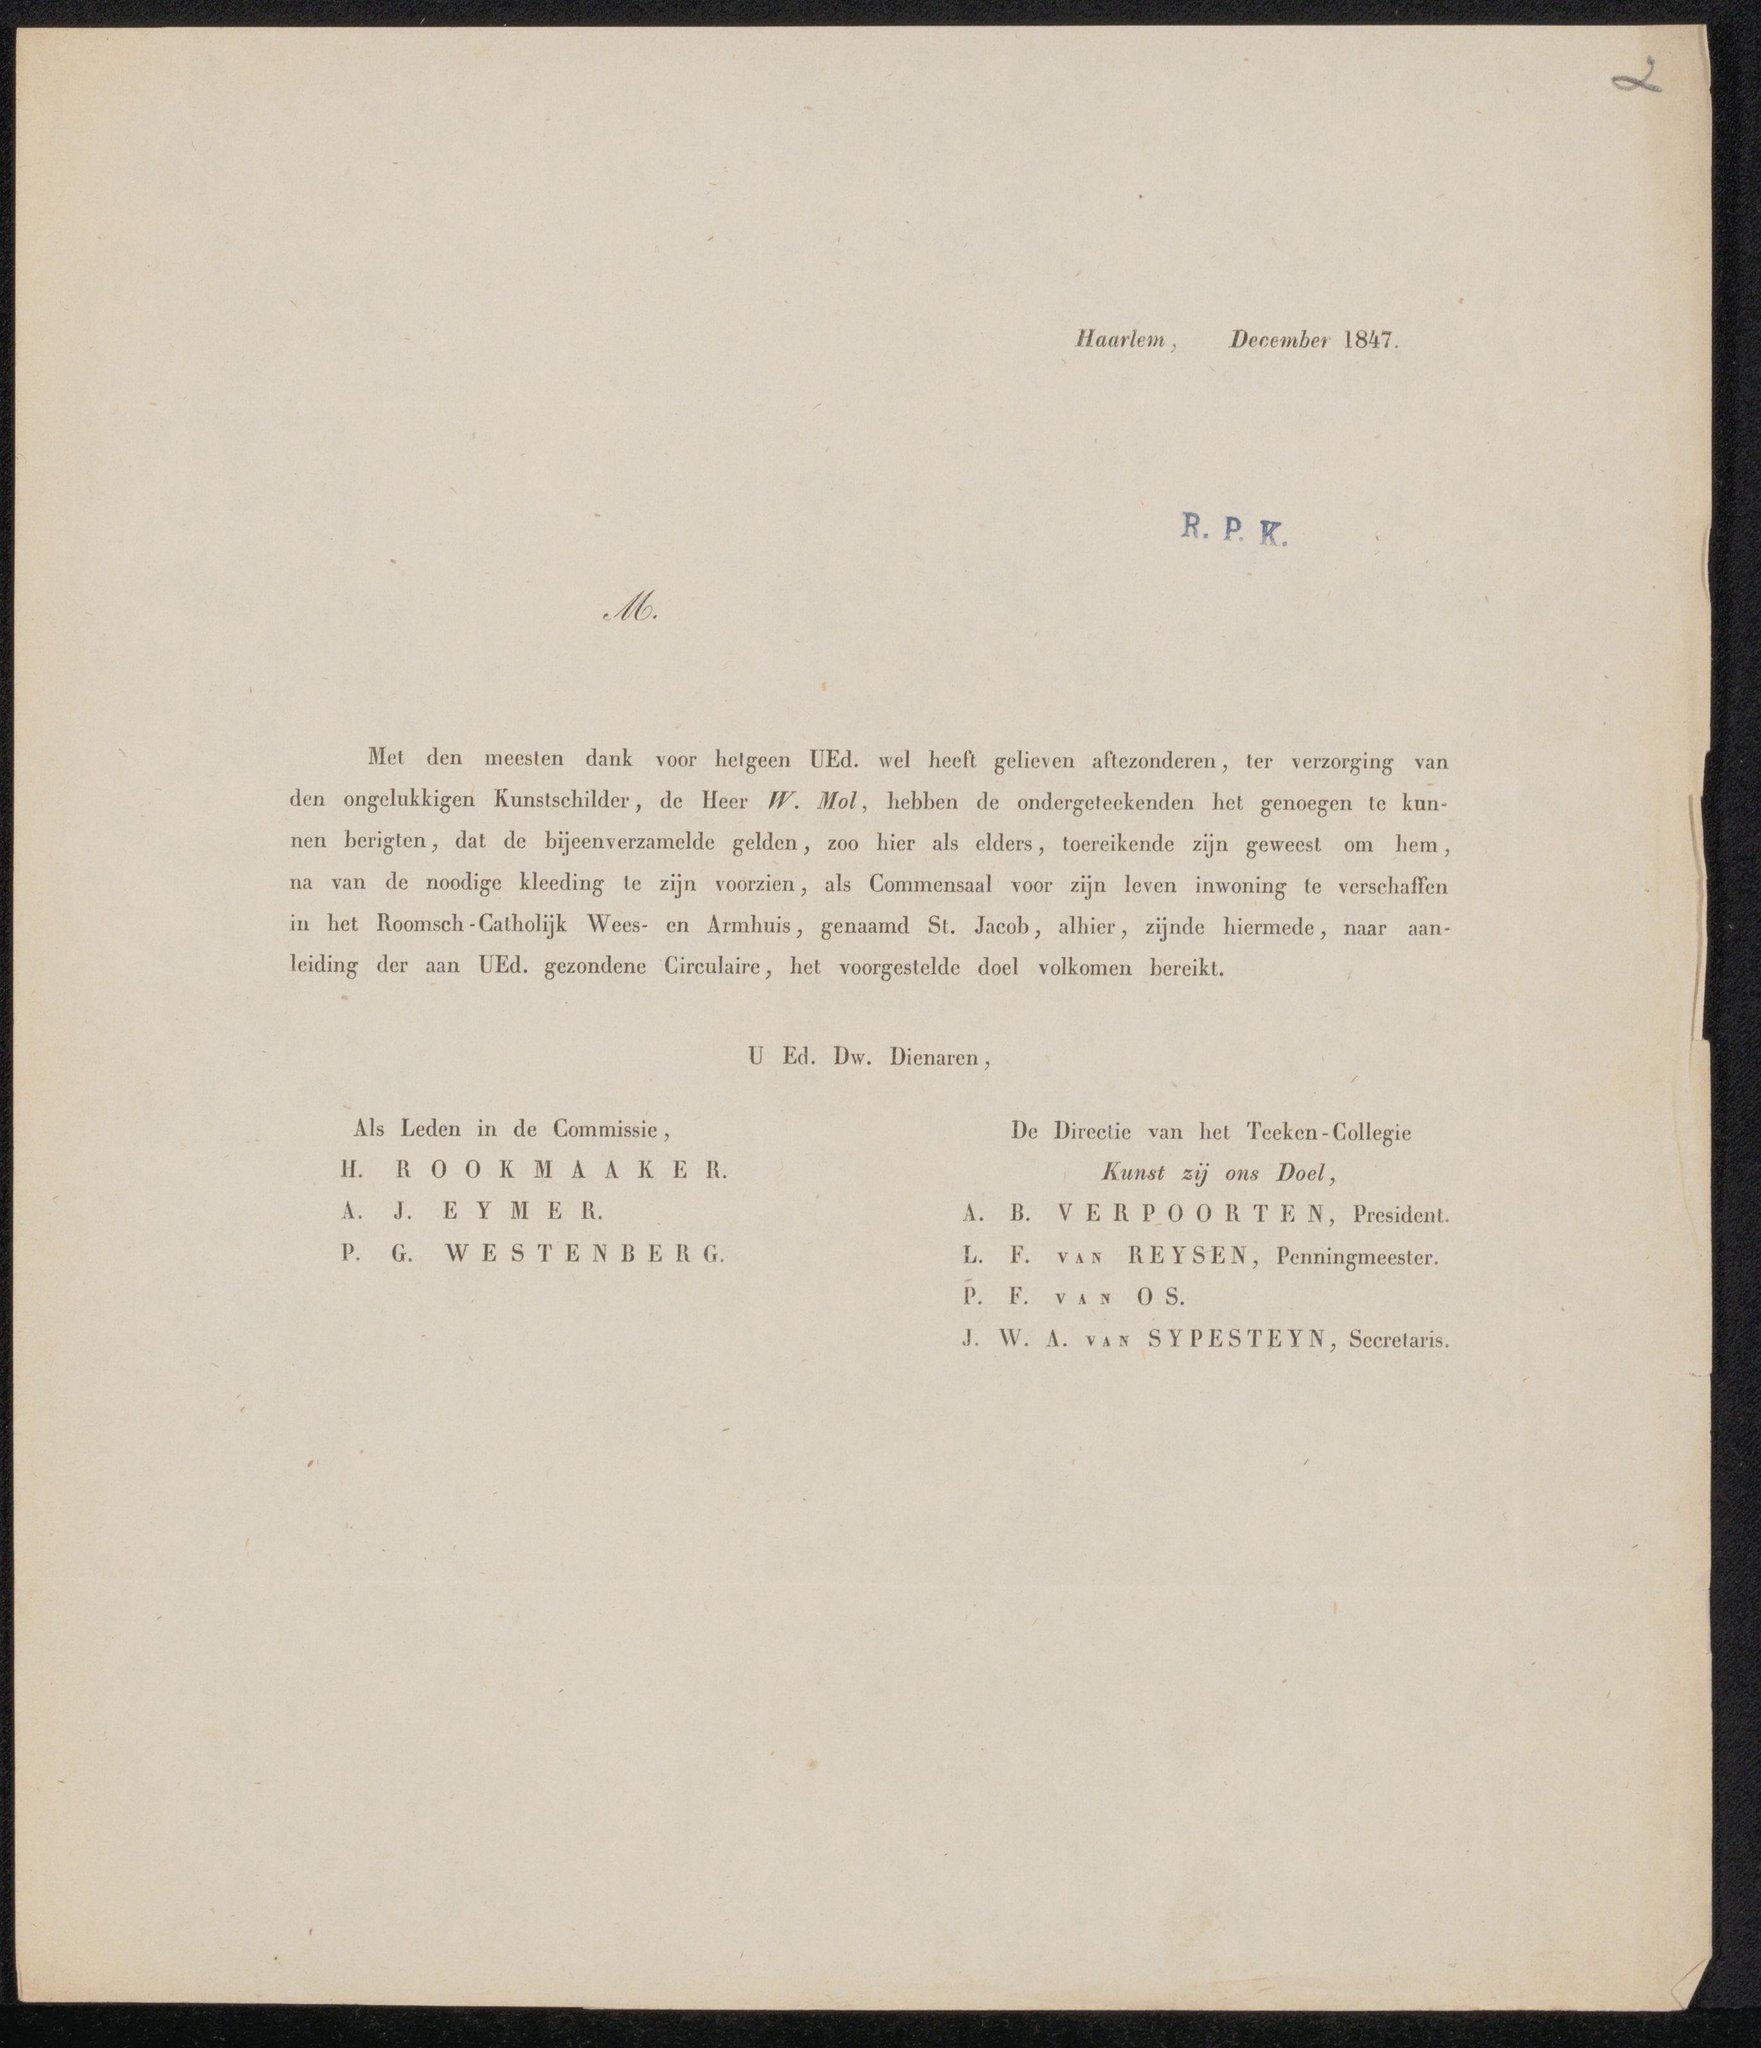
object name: letter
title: Brief aan anoniem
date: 1812-1847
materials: paper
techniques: printing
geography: haarlem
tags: haarlem, painter, draughtsman, woutherus mol, diseases, charitable works, money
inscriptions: collector's mark: Lugt 2233